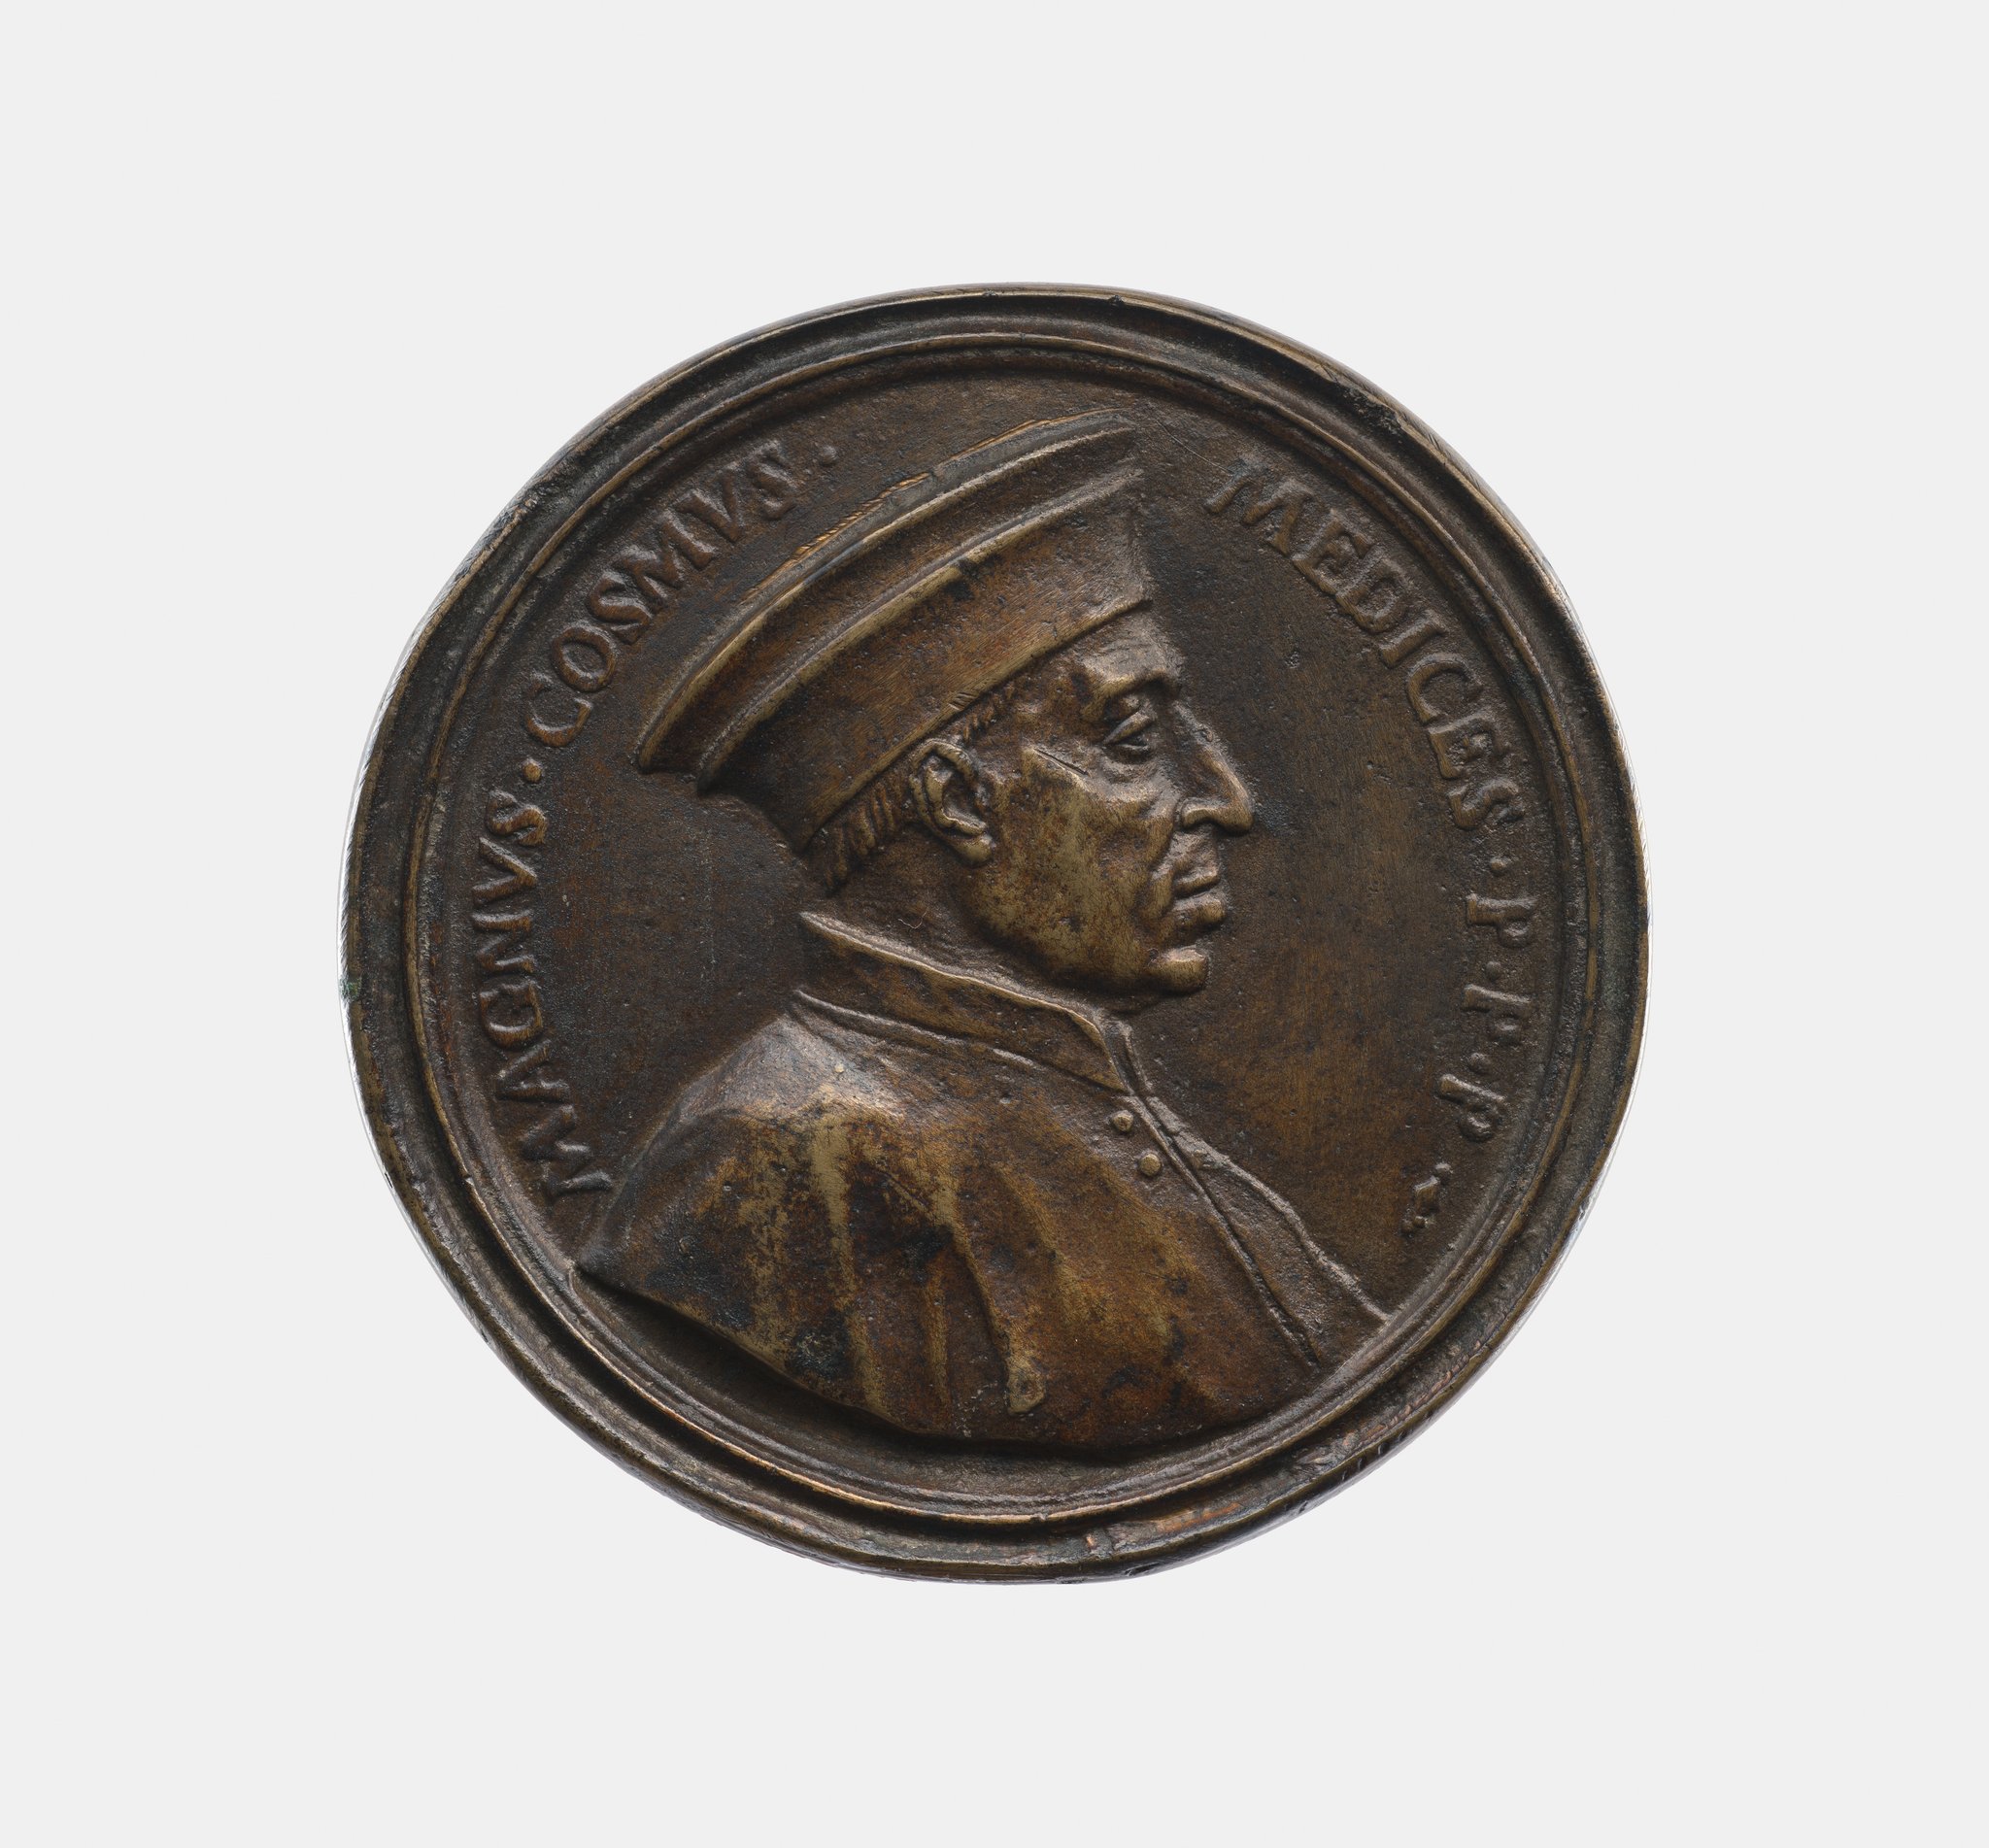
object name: medal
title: Cosimo I de' Medici 1519-74, Duke of Florence 1537-69, Grand Duke of Tuscany 1569-74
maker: antonio francesco selvi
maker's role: artist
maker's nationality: italian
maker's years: 1679-1755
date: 1689-1755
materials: bronze